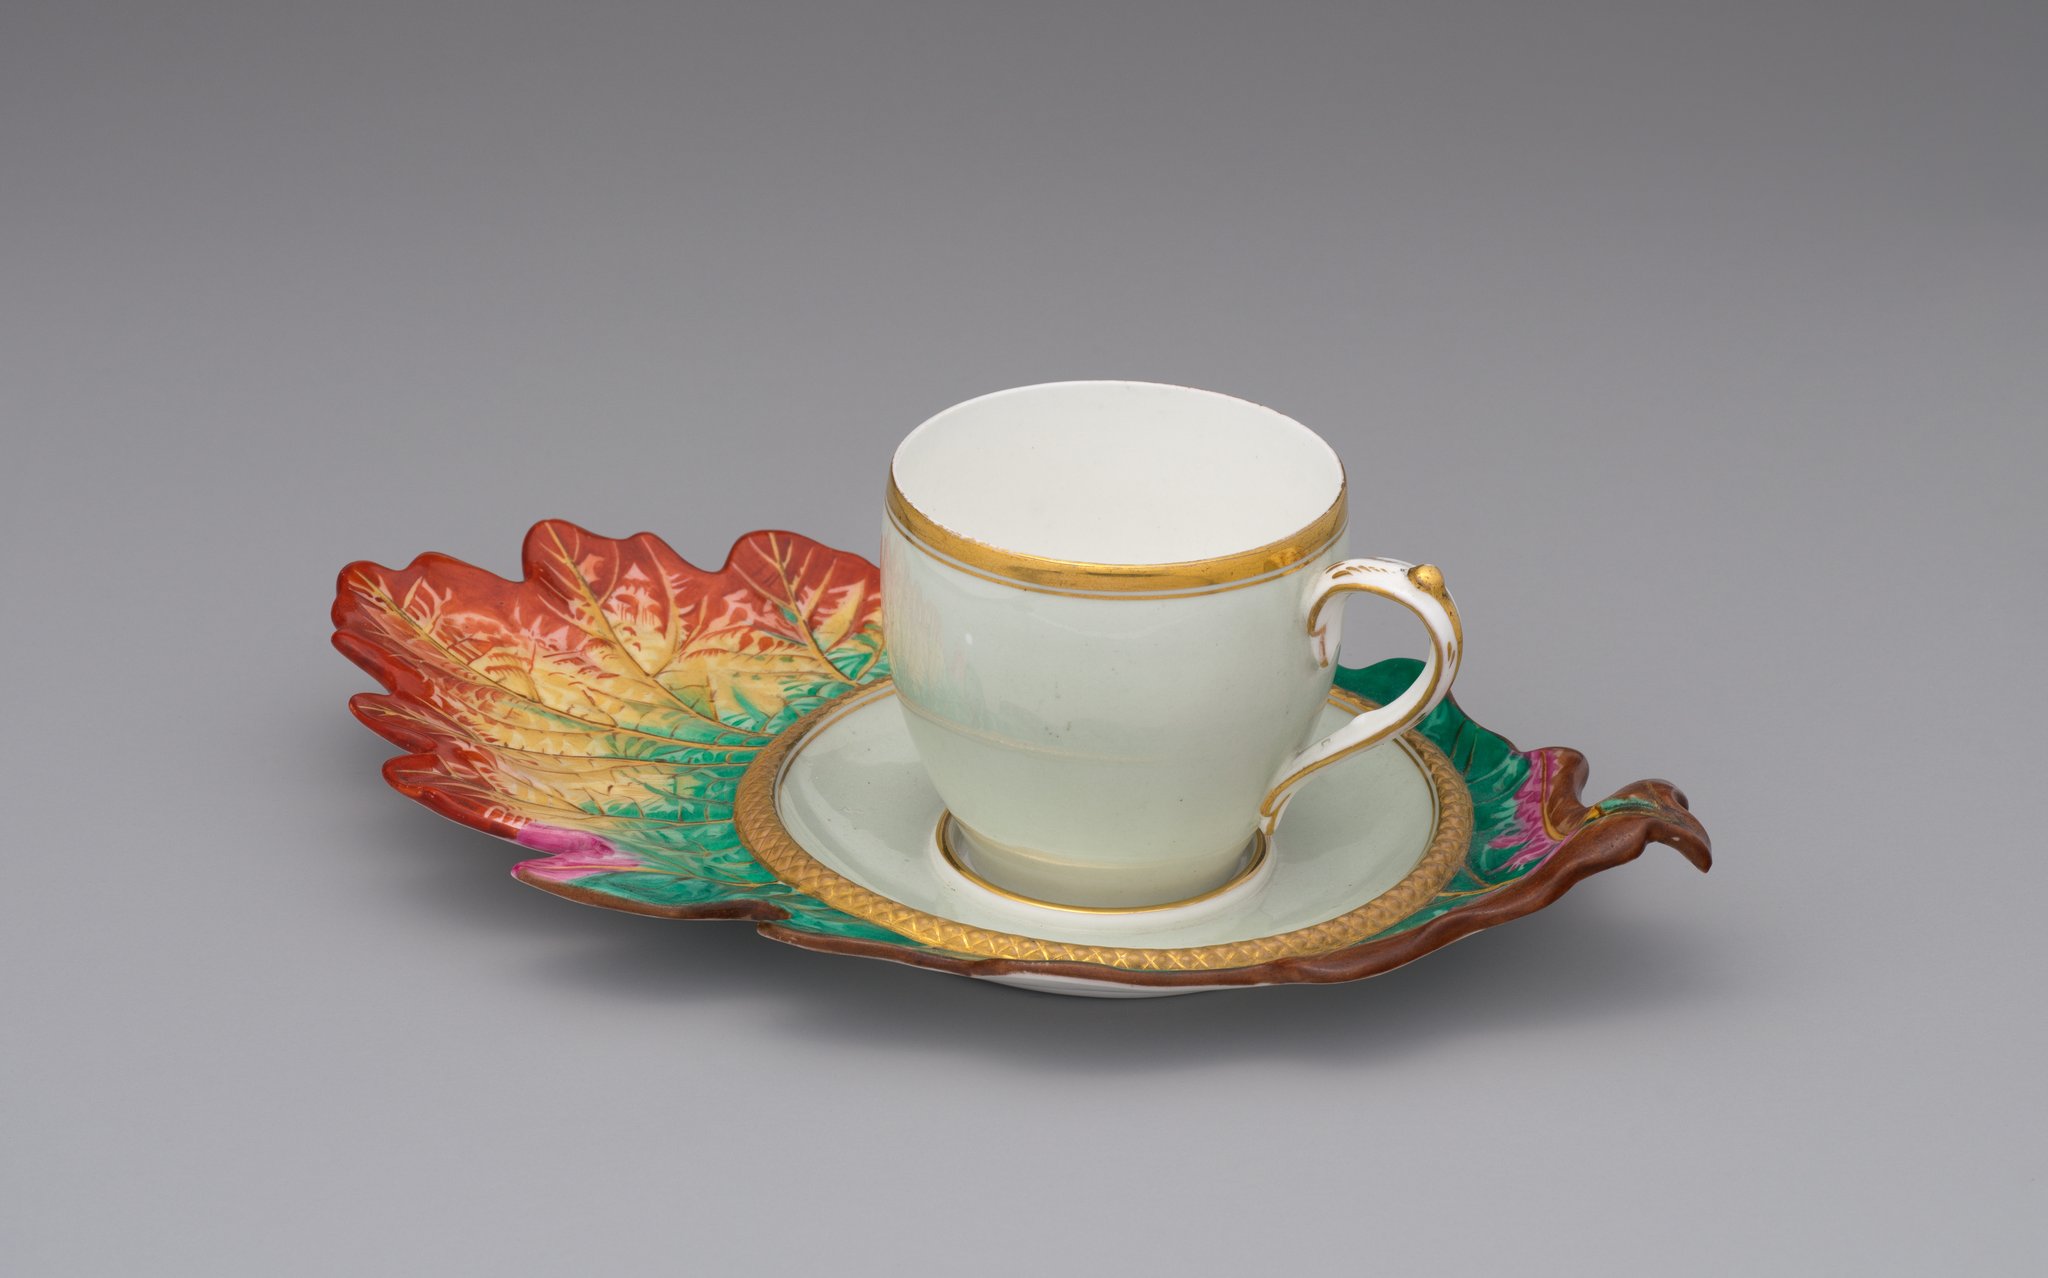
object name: cup and saucer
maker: copeland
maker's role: factory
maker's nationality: british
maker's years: 1833-1970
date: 1871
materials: bone china